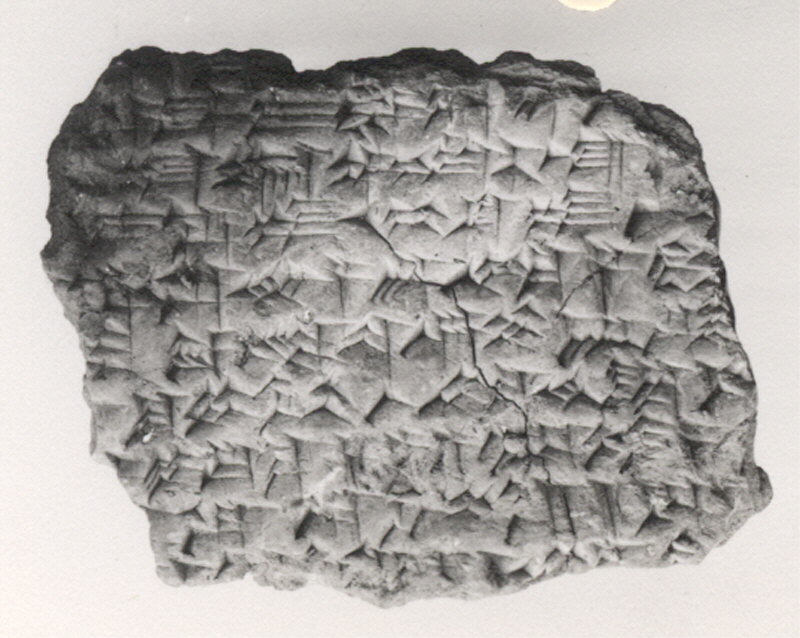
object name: cuneiform tablet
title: Cuneiform tablet: ritual fragment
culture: achaemenid or seleucid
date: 667-1 BCE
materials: clay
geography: mesopotamia